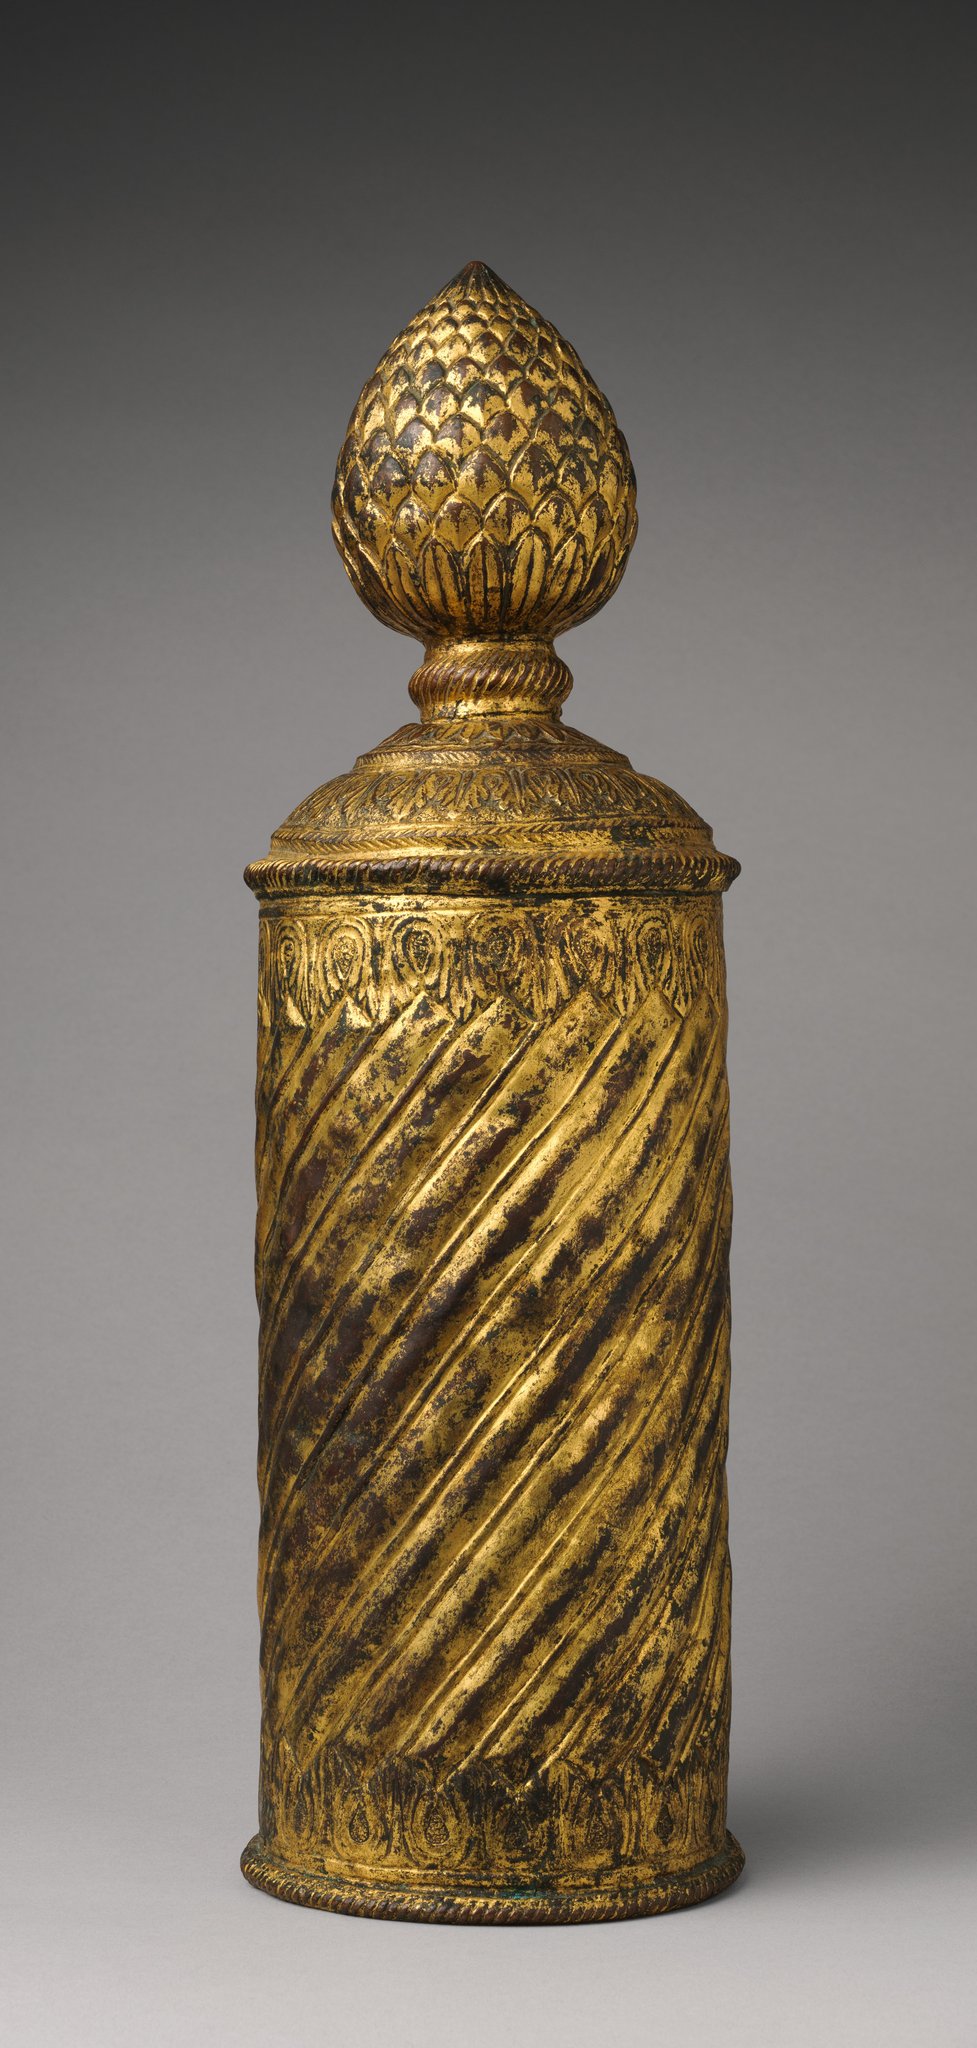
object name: finial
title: Palanquin Finial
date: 1650-1680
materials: copper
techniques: casting, gilding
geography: india